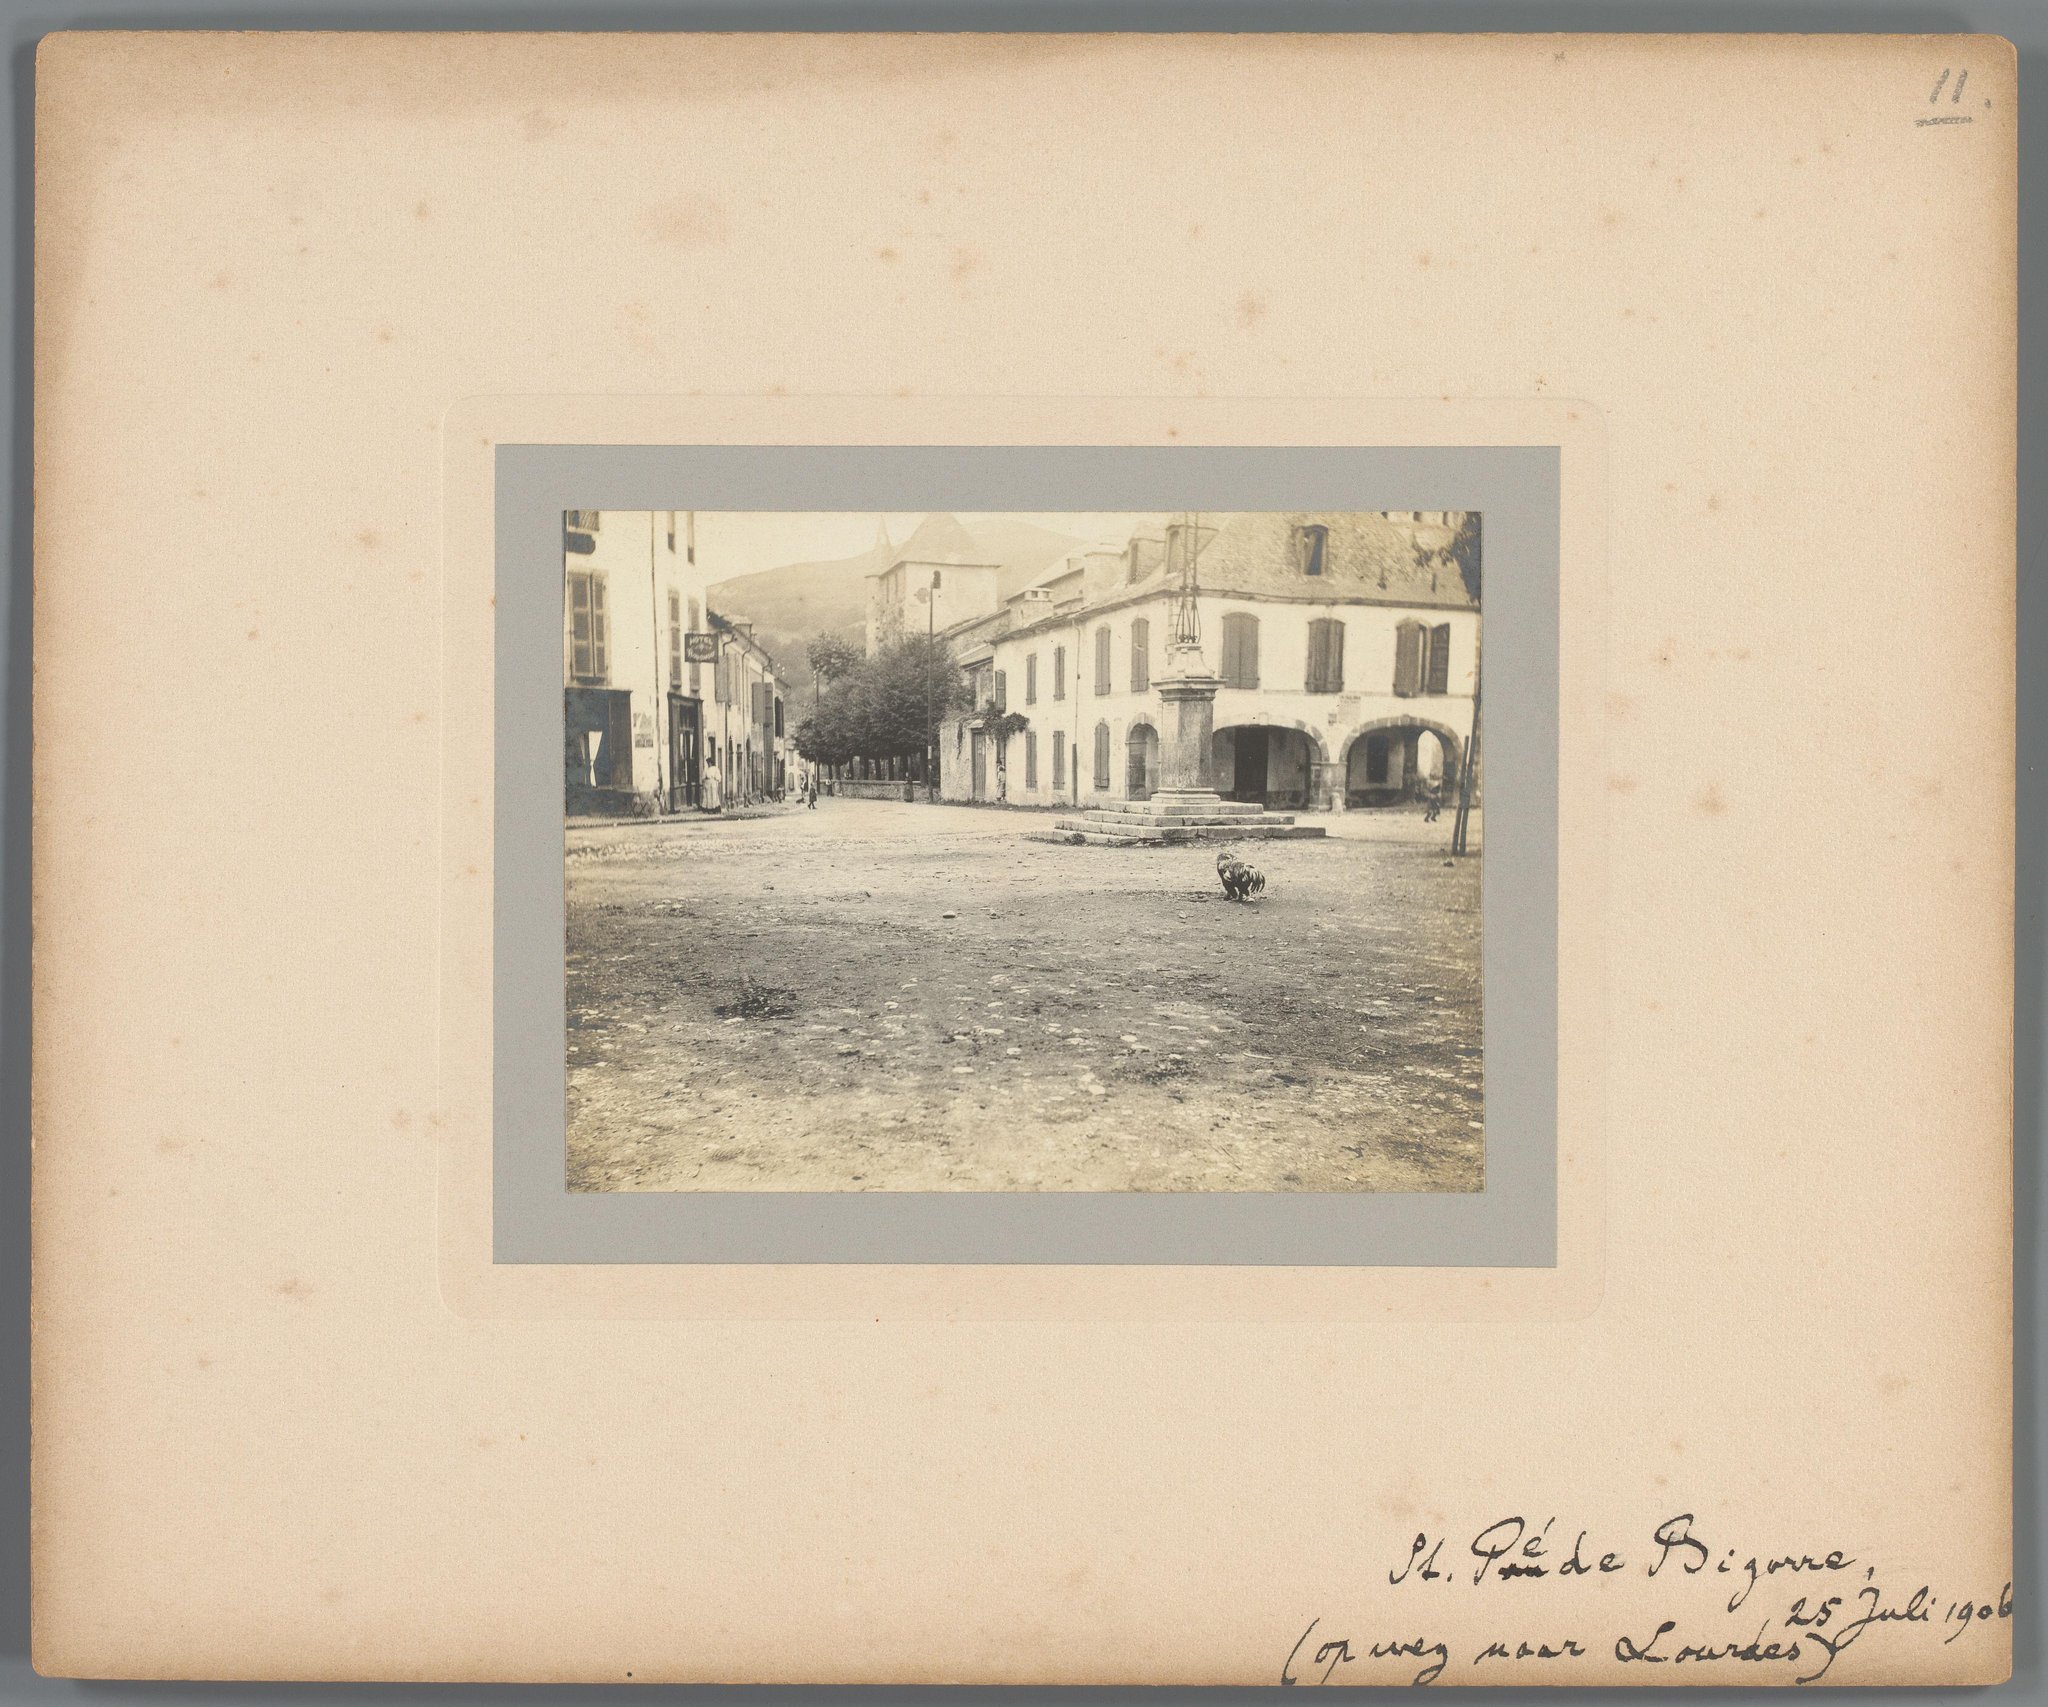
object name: photograph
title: Plein in Saint-Pé-de-Bigorre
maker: françois buys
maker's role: advocaat, amateurfotograaf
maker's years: 1871-1934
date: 1906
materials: paper, cardboard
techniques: gelatin silver print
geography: saint-pé-de-bigorre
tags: square, place, circus, etc.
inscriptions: number: ‘11’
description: Deze foto maakt deel uit van een groep van 49 foto's.